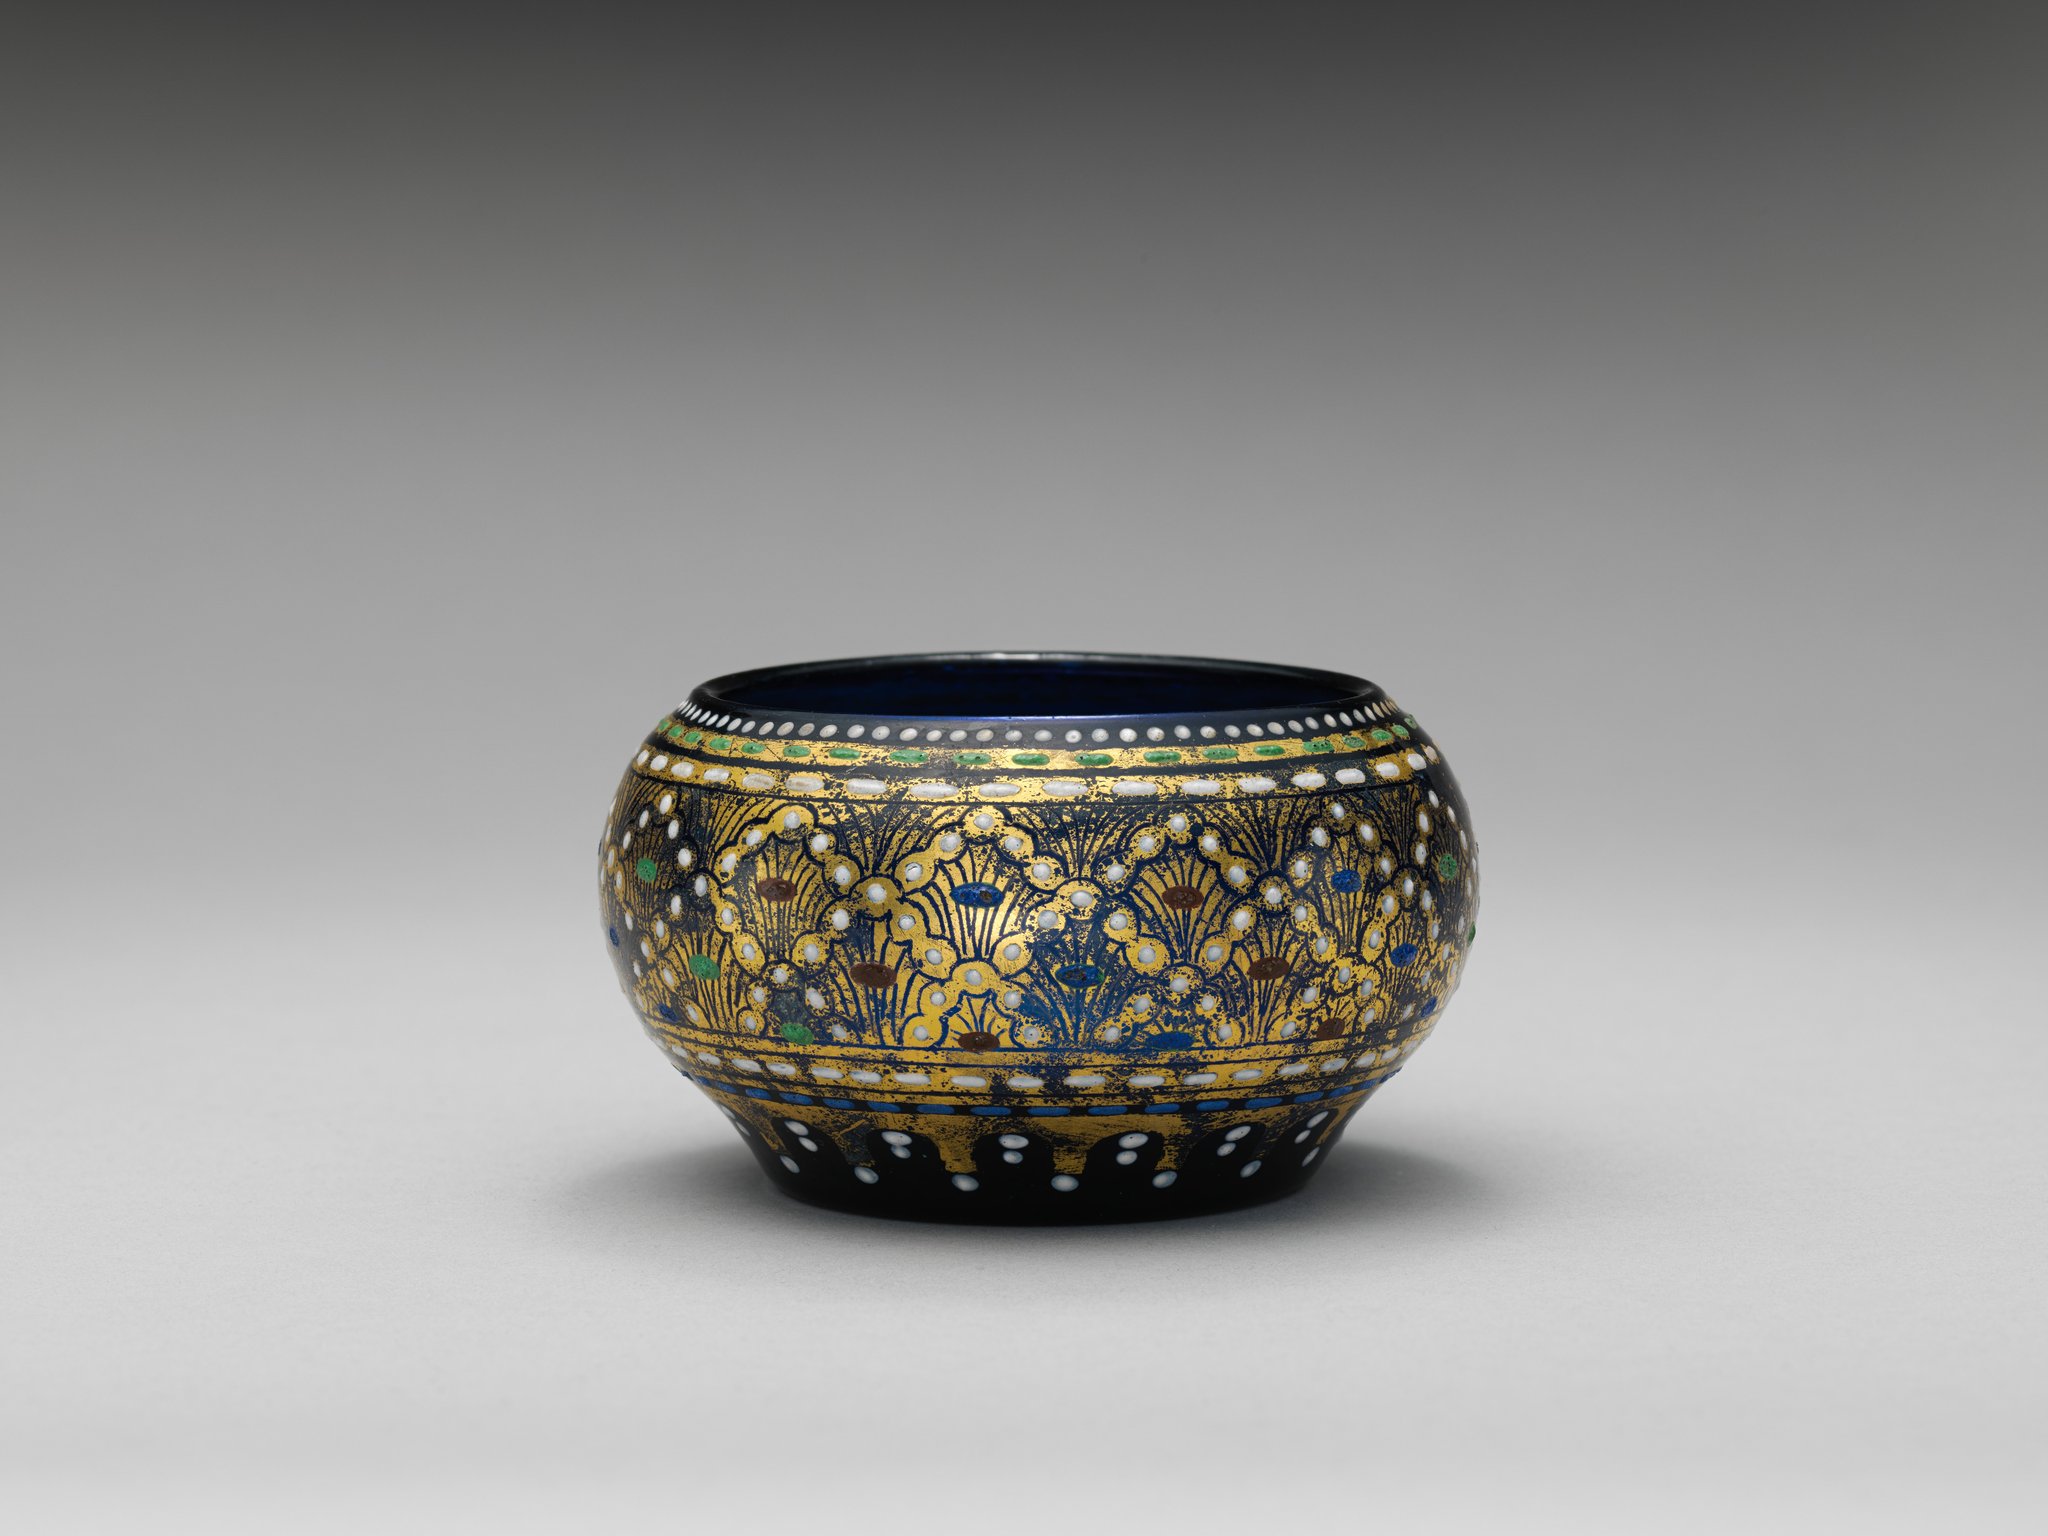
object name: bowl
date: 1501-1600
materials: gilt, glass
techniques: enamel